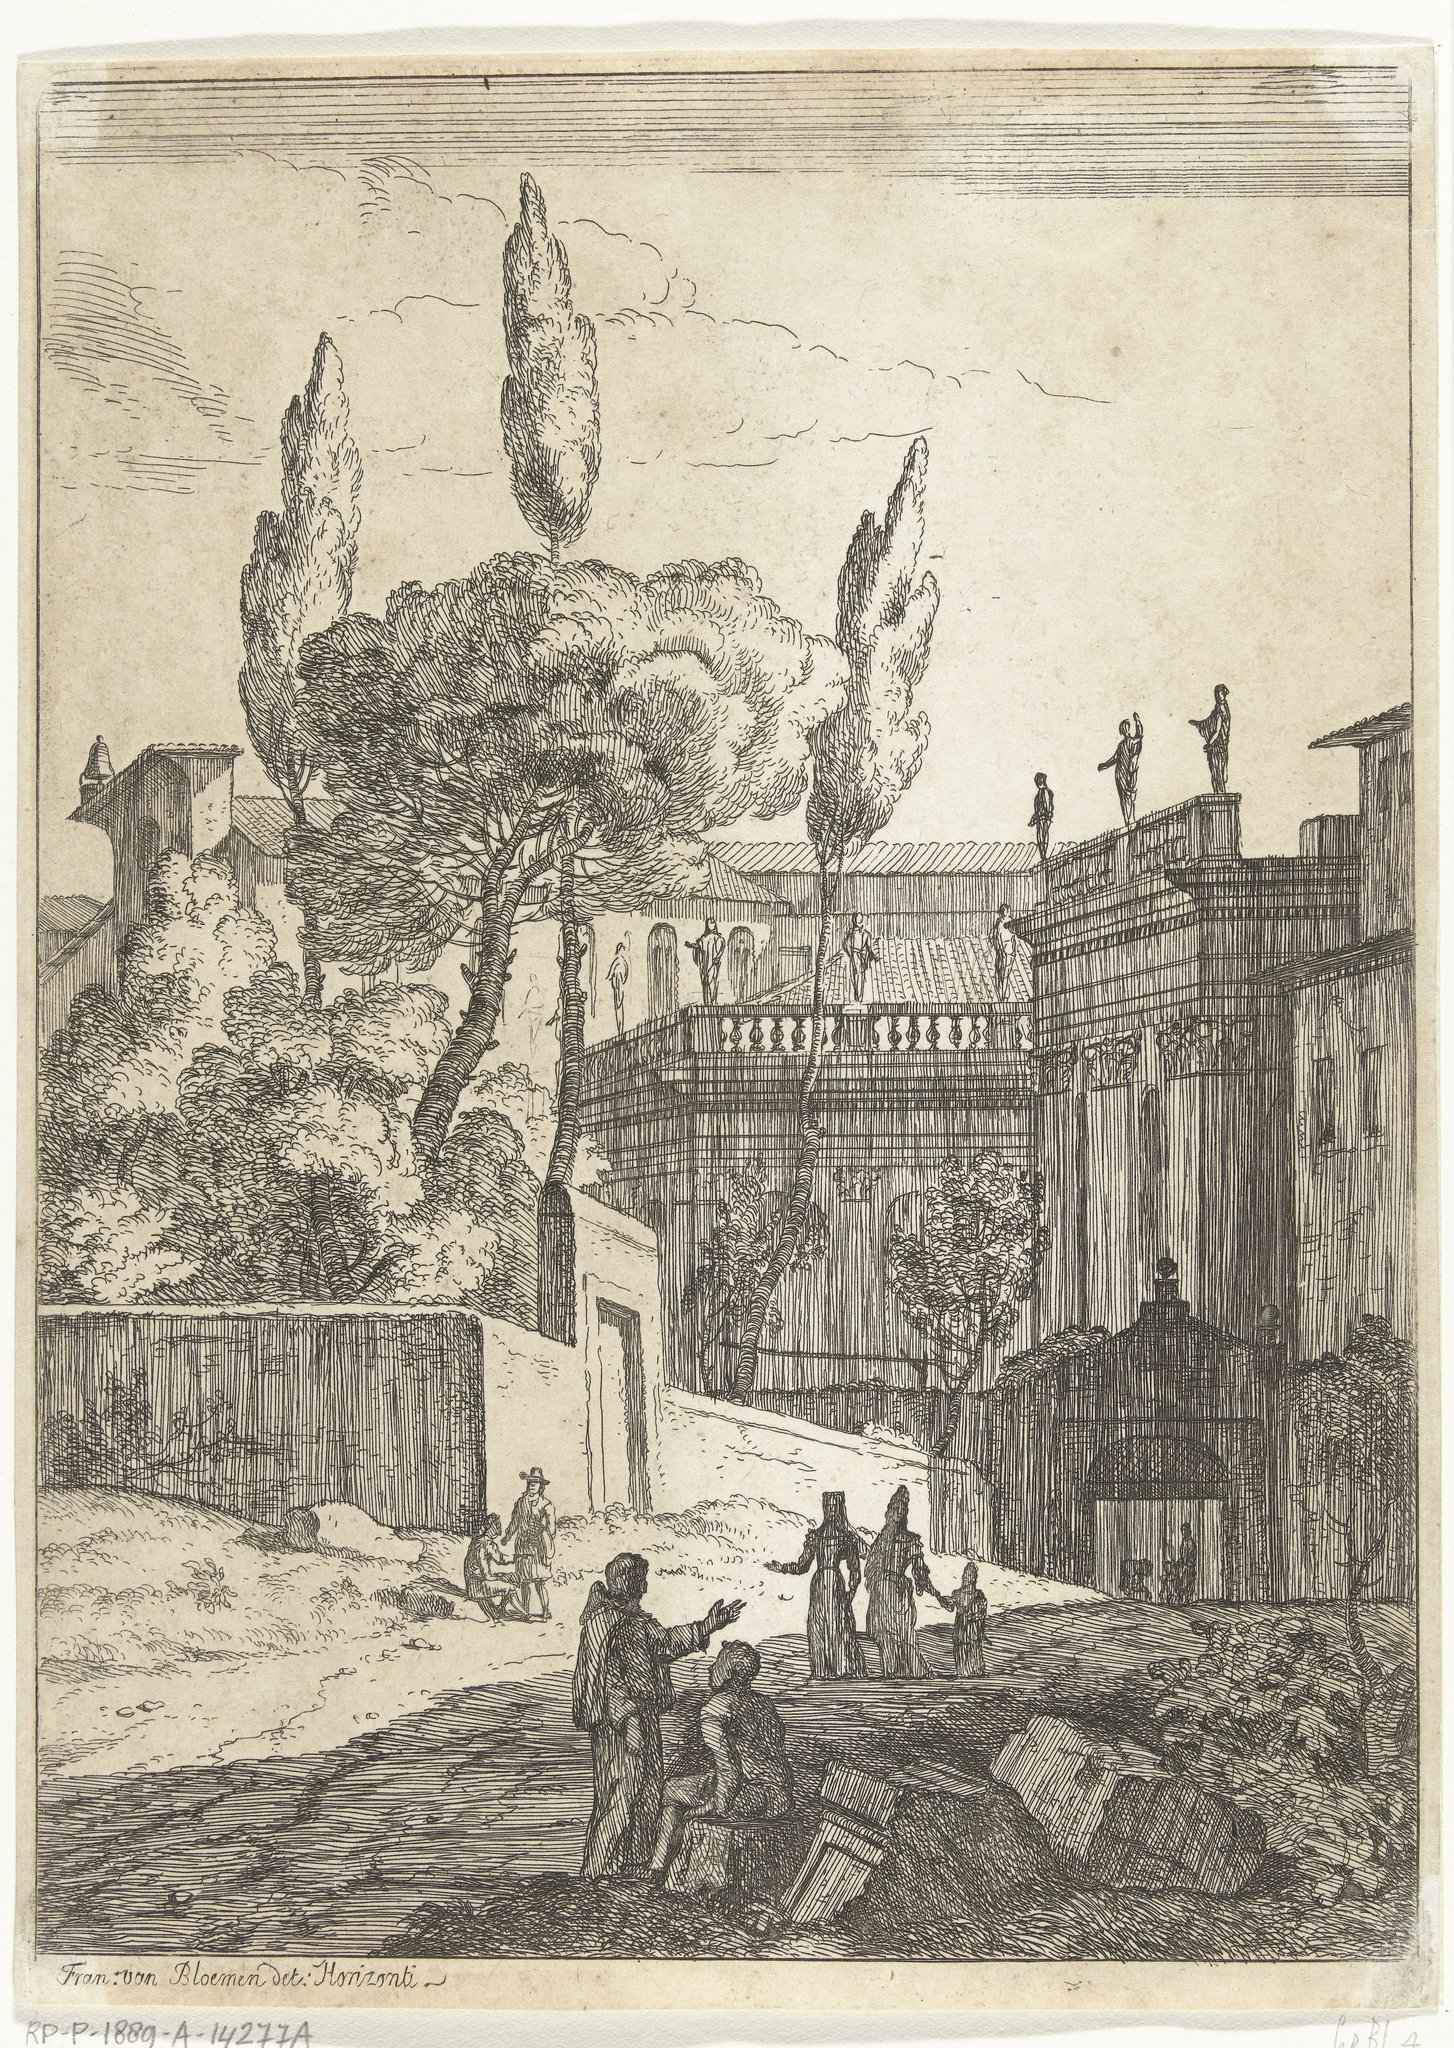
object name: print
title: Italianiserend landschap met antieke gebouwen en figuren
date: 1689-1749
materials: paper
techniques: etching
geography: rome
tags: landscape with tower or castle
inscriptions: collector's mark: Lugt 2228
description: Prent mogelijk naar schilderij van Titiaan.